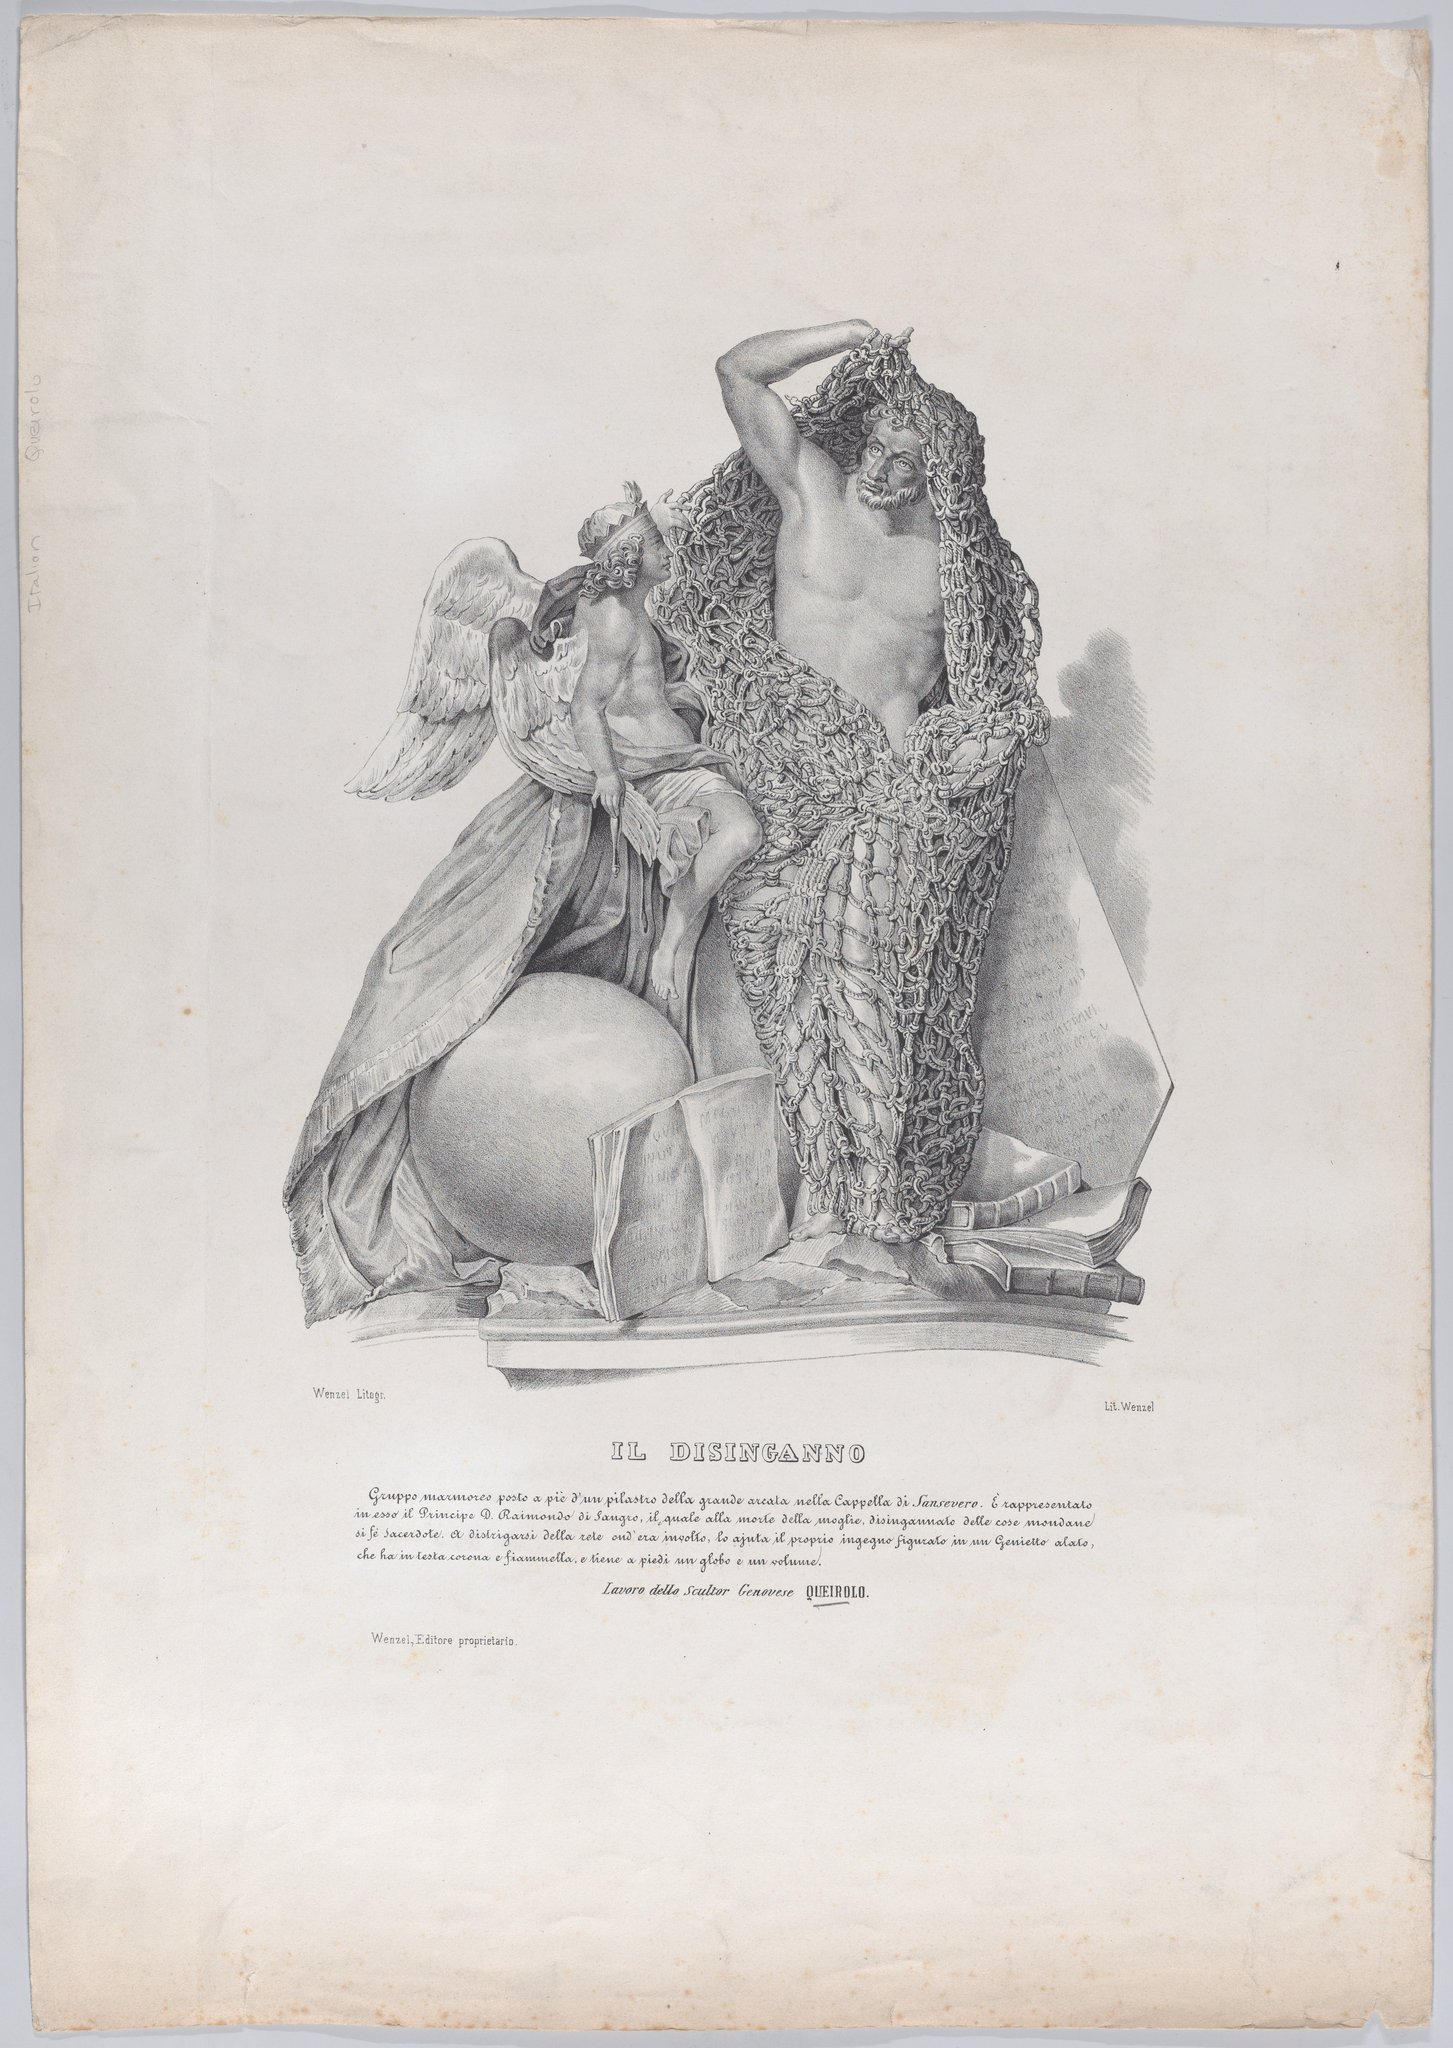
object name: print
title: Prince Raimondo di Sangro disentangling himself from the net of worldly cares with the help of his winged genius, after the marble statue by Francesco Queirolo in the Capella di Sansevero, Naples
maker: francesco wenzel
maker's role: artist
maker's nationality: italian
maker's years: 1827-1850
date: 1840-1850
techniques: lithograph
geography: naples